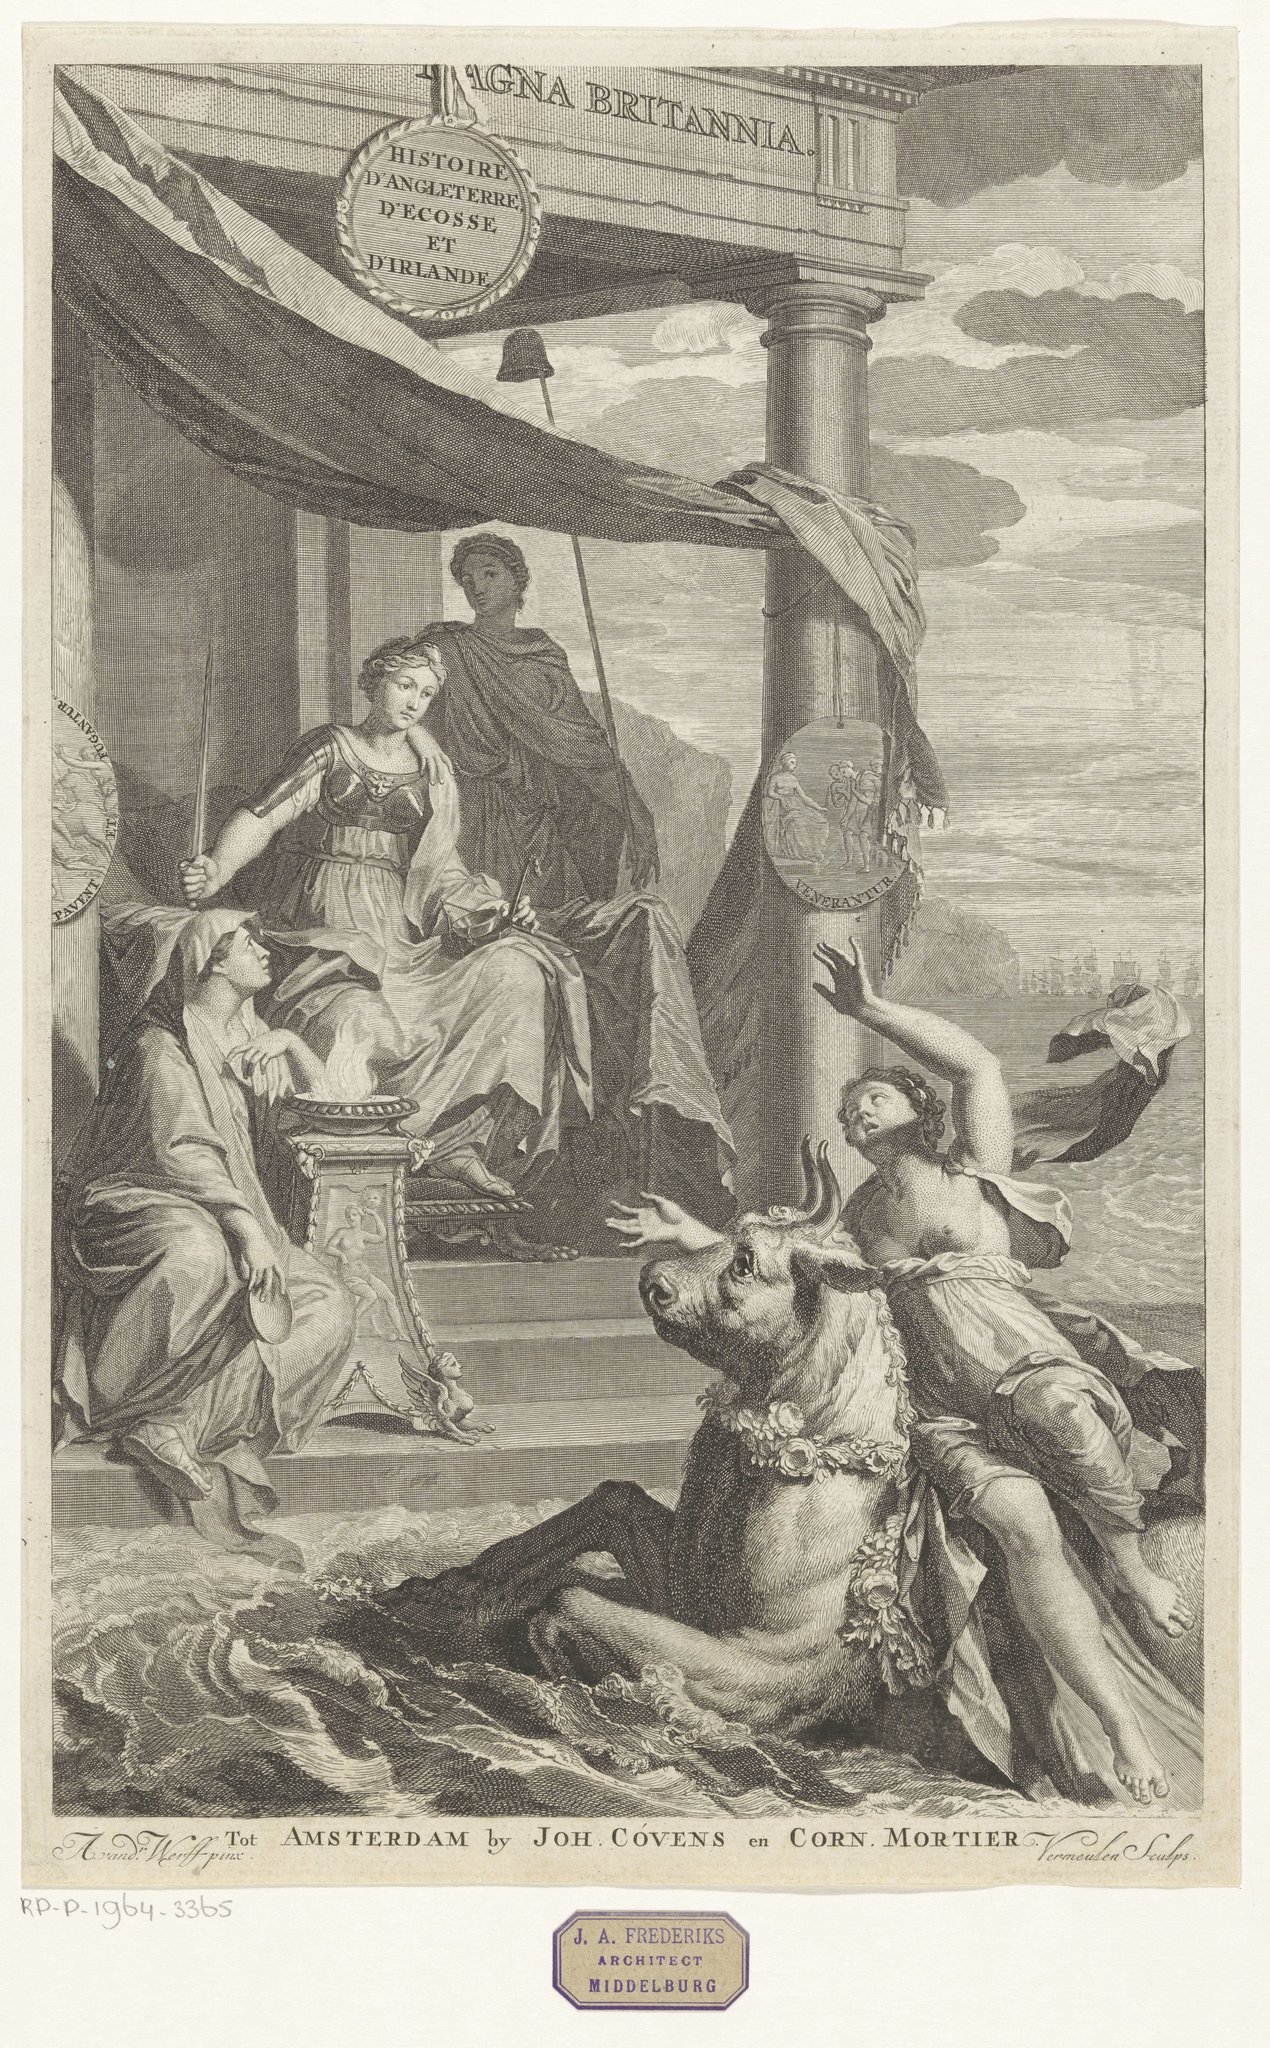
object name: print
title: Titelpagina voor: Isaac de Larrey, Histoire d'Angleterre d'Ecosse et d'Irlande, s.a.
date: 1697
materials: paper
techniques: engraving, etching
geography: amsterdam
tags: jupiter, usually in the shape of a white bull, abducts europa and carries her across the water, personifications of countries, nations, states, districts, etc., justitia (justice) as roman personification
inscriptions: collector's mark: Lugt 2228, stamp: ‘J.A. Frederiks architect Middelburg’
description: De ontvoering van Europa door Jupiter in de gedaante van een stier. Britannia, gepersonifieerd door Themis als personificatie van Gerechtigheid, zit met weegschaal en zwaard getroond tussen twee zuilen onder een draperie en kijkt toe. Links zit een vrouw naast een brandend altaar. Rechts staat een vrouw met lans met vrijheidshoed. In de achtergrond een vloot.